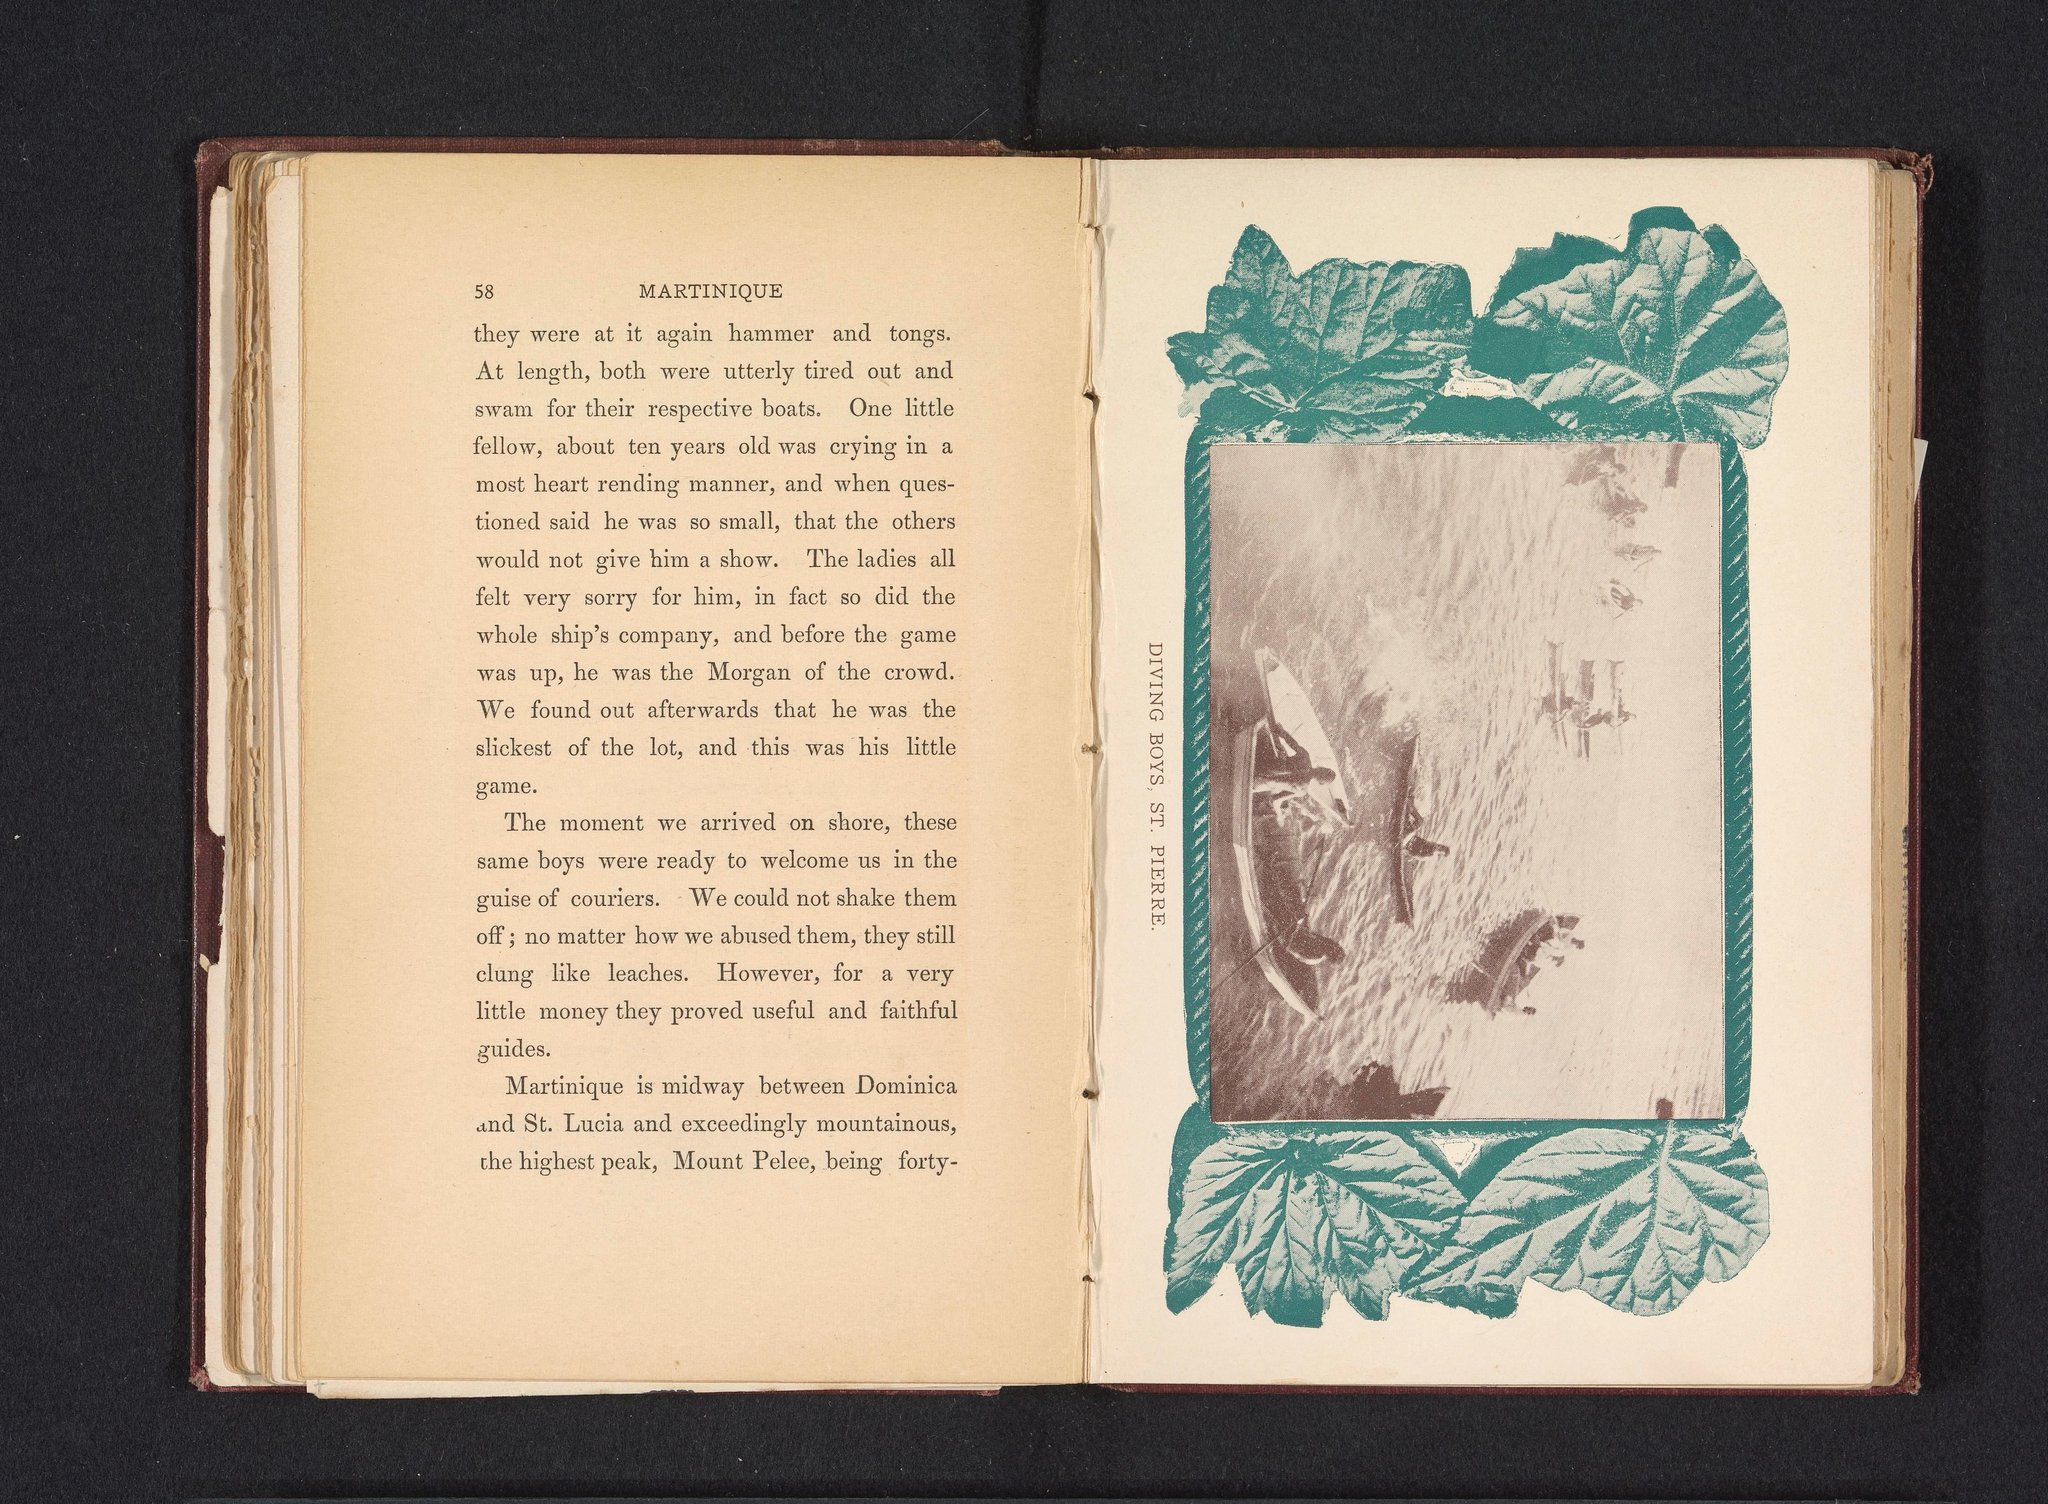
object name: page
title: Gezicht op jongens die van boten in zee duiken bij Saint-Pierre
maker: Anonymous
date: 1892-1902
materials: paper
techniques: autotype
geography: saint-pierre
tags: diving (movement in water)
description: Prent in apart gedrukte omlijsting met bladmotief.